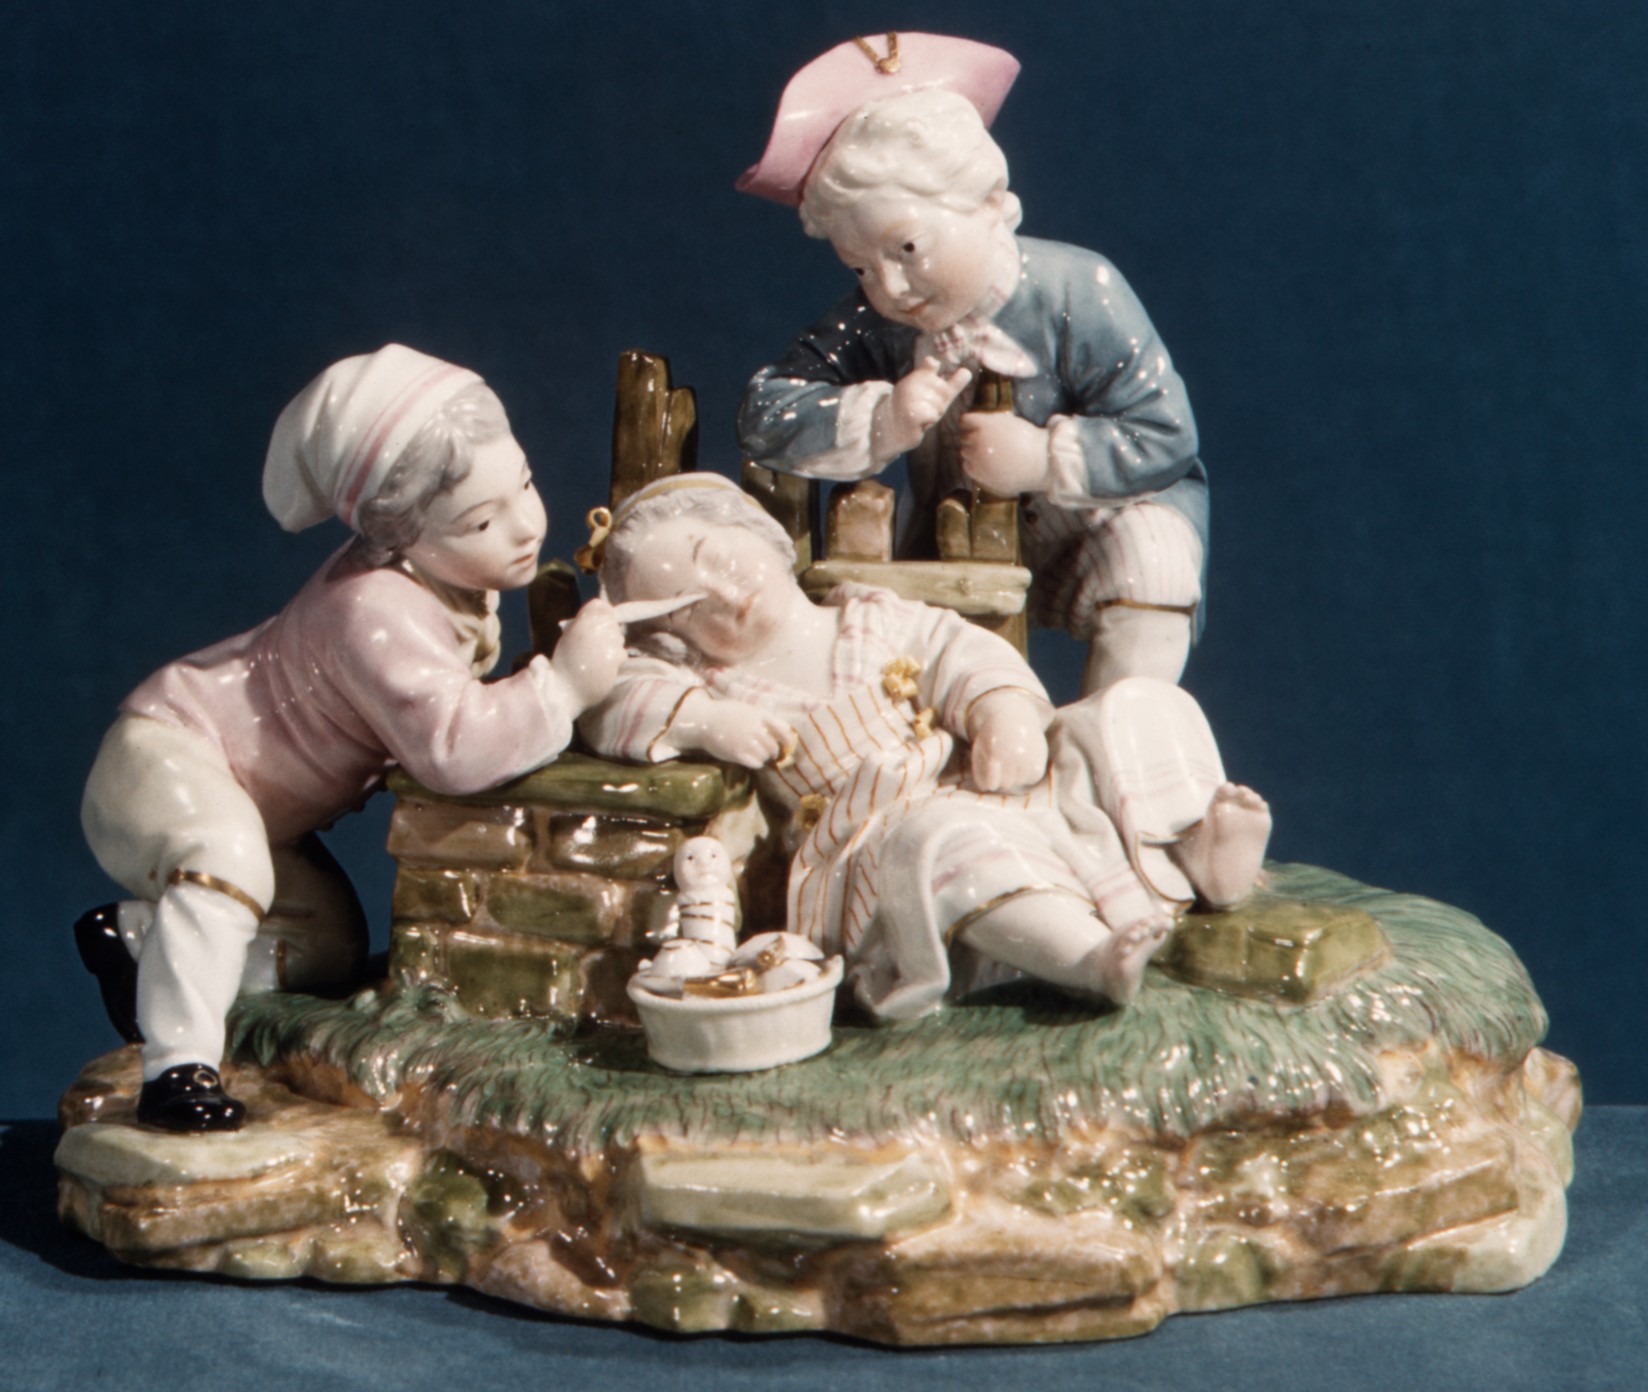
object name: group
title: Disturbed Slumber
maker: höchst manufactory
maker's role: manufactory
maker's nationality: german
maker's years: 1746-1796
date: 1770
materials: hard paste porcelain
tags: sleeping,children